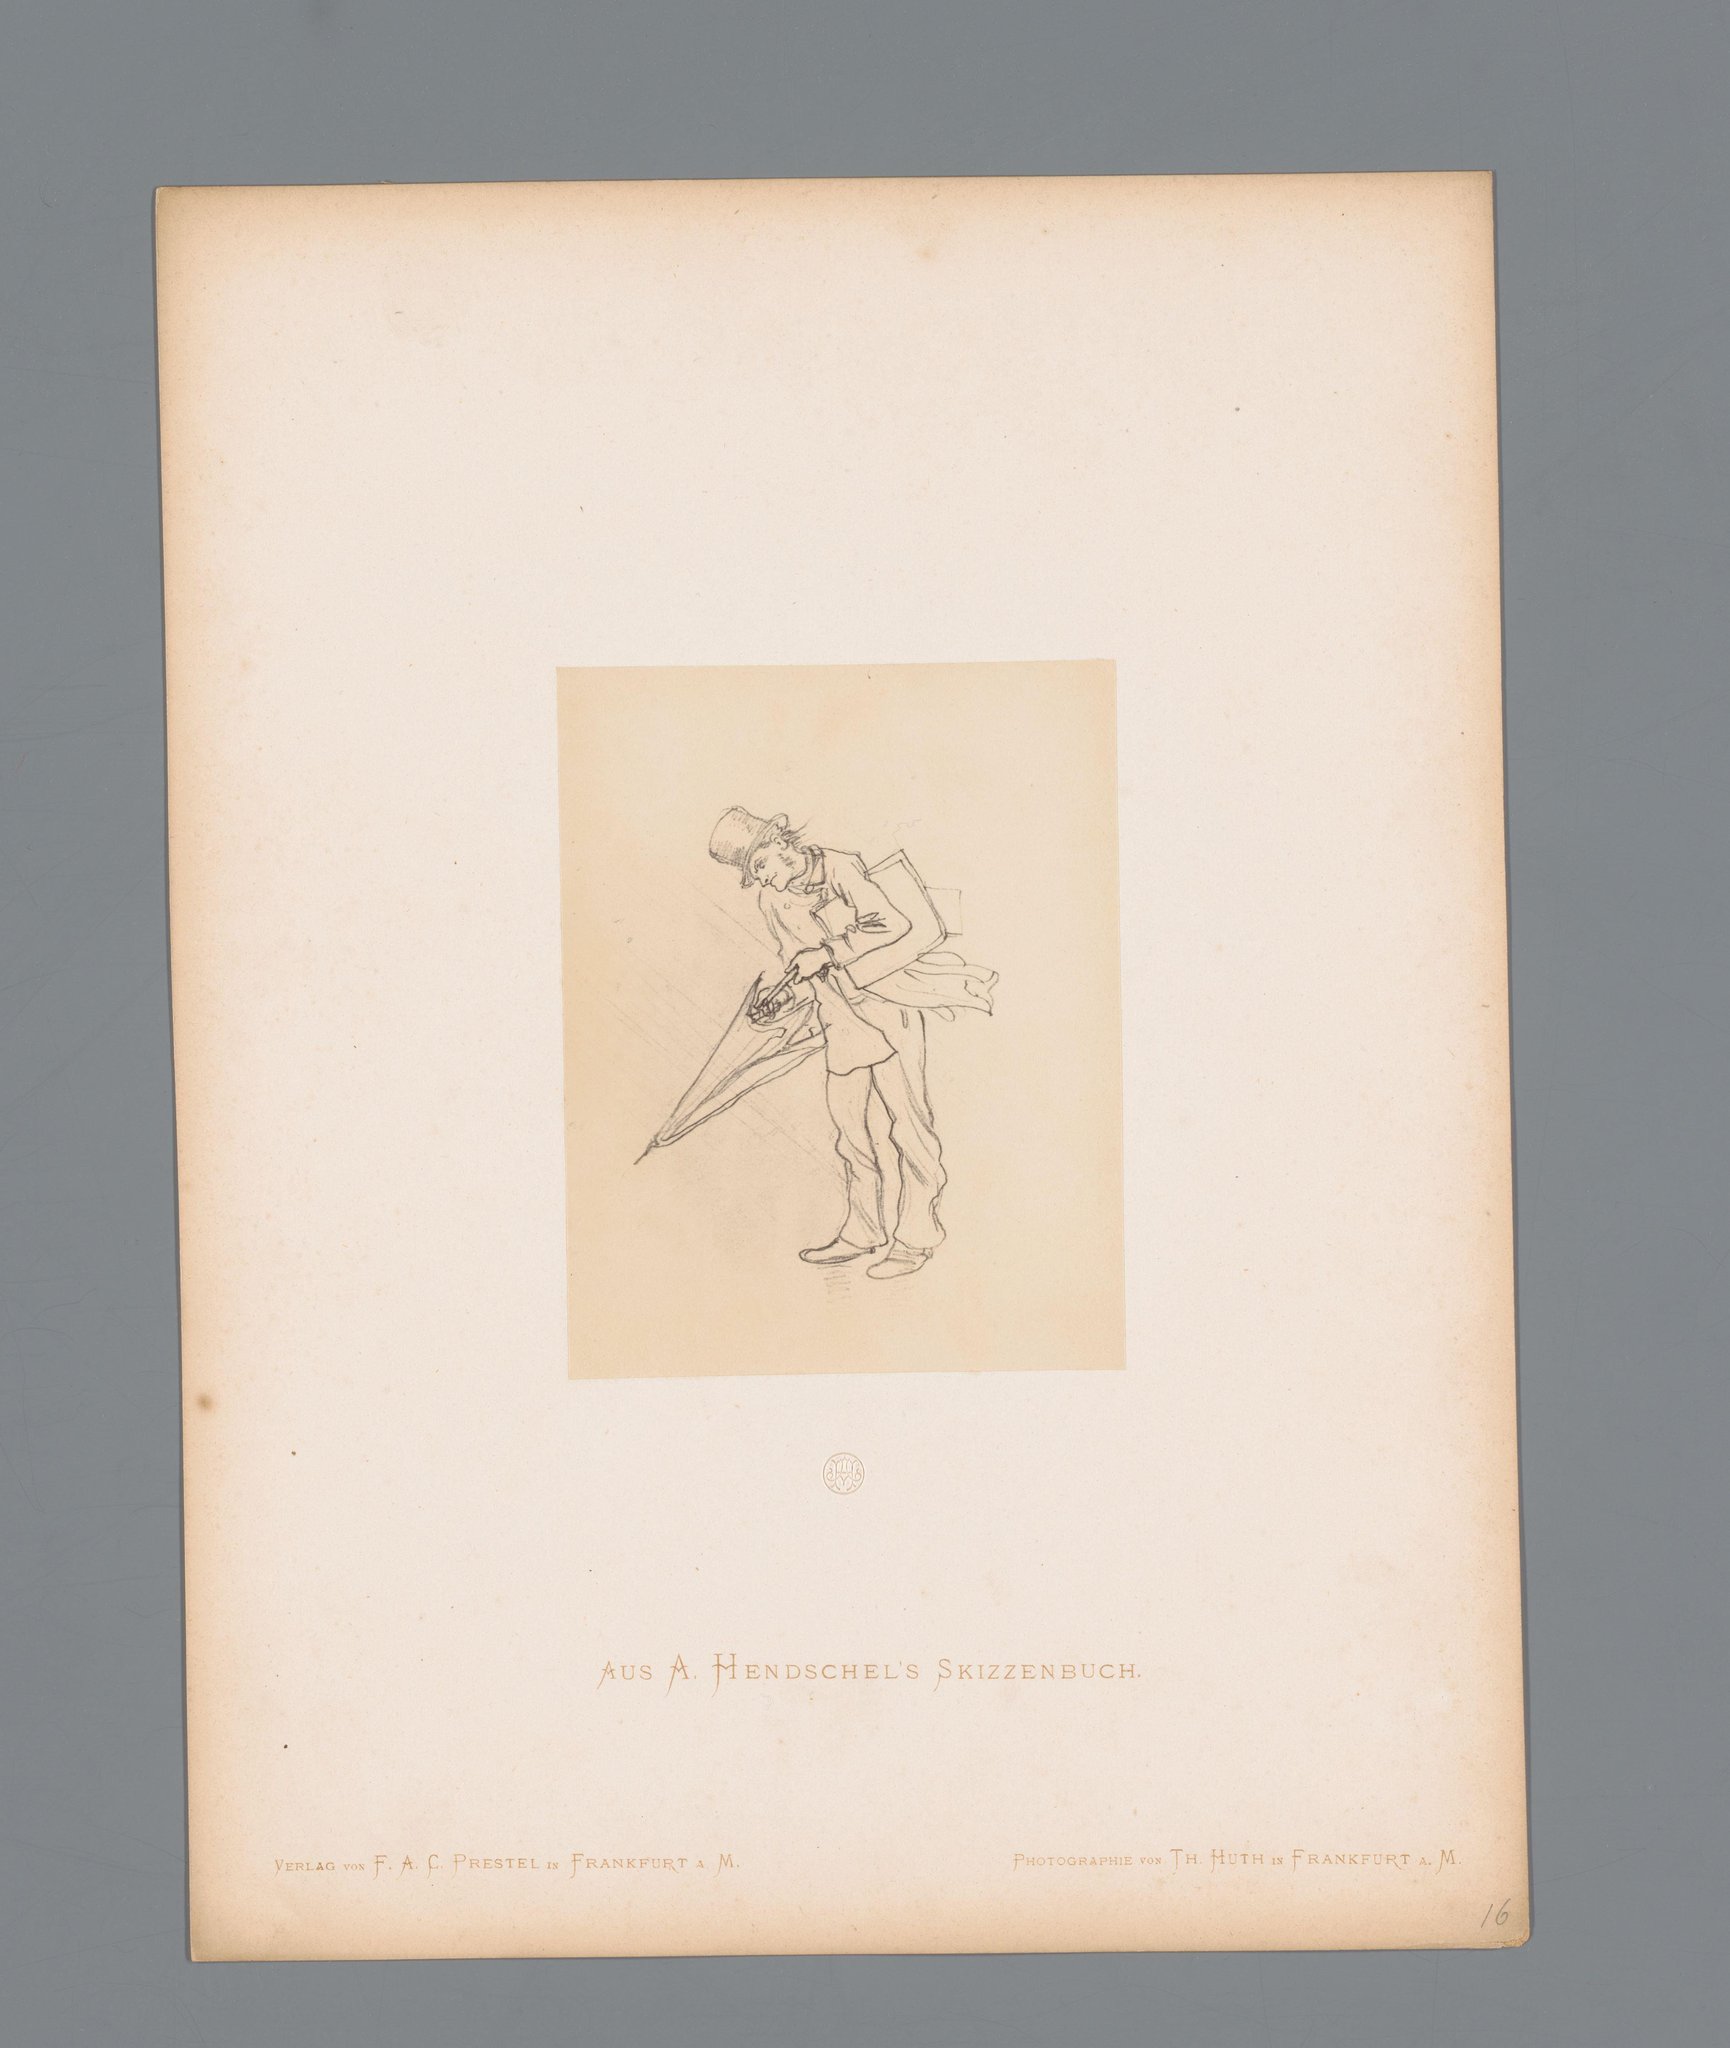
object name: photograph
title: Aus A. Hendschel's Skizzenbuch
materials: photographic support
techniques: albumen print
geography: frankfurt am main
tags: downpour, rain shower, adult man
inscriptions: number: ‘16’, monogram: ‘AH’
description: Deze foto maakt deel uit van een omslag met 50 foto's op 48 bladen, een lijst van afbeeldingen en een titelblad.